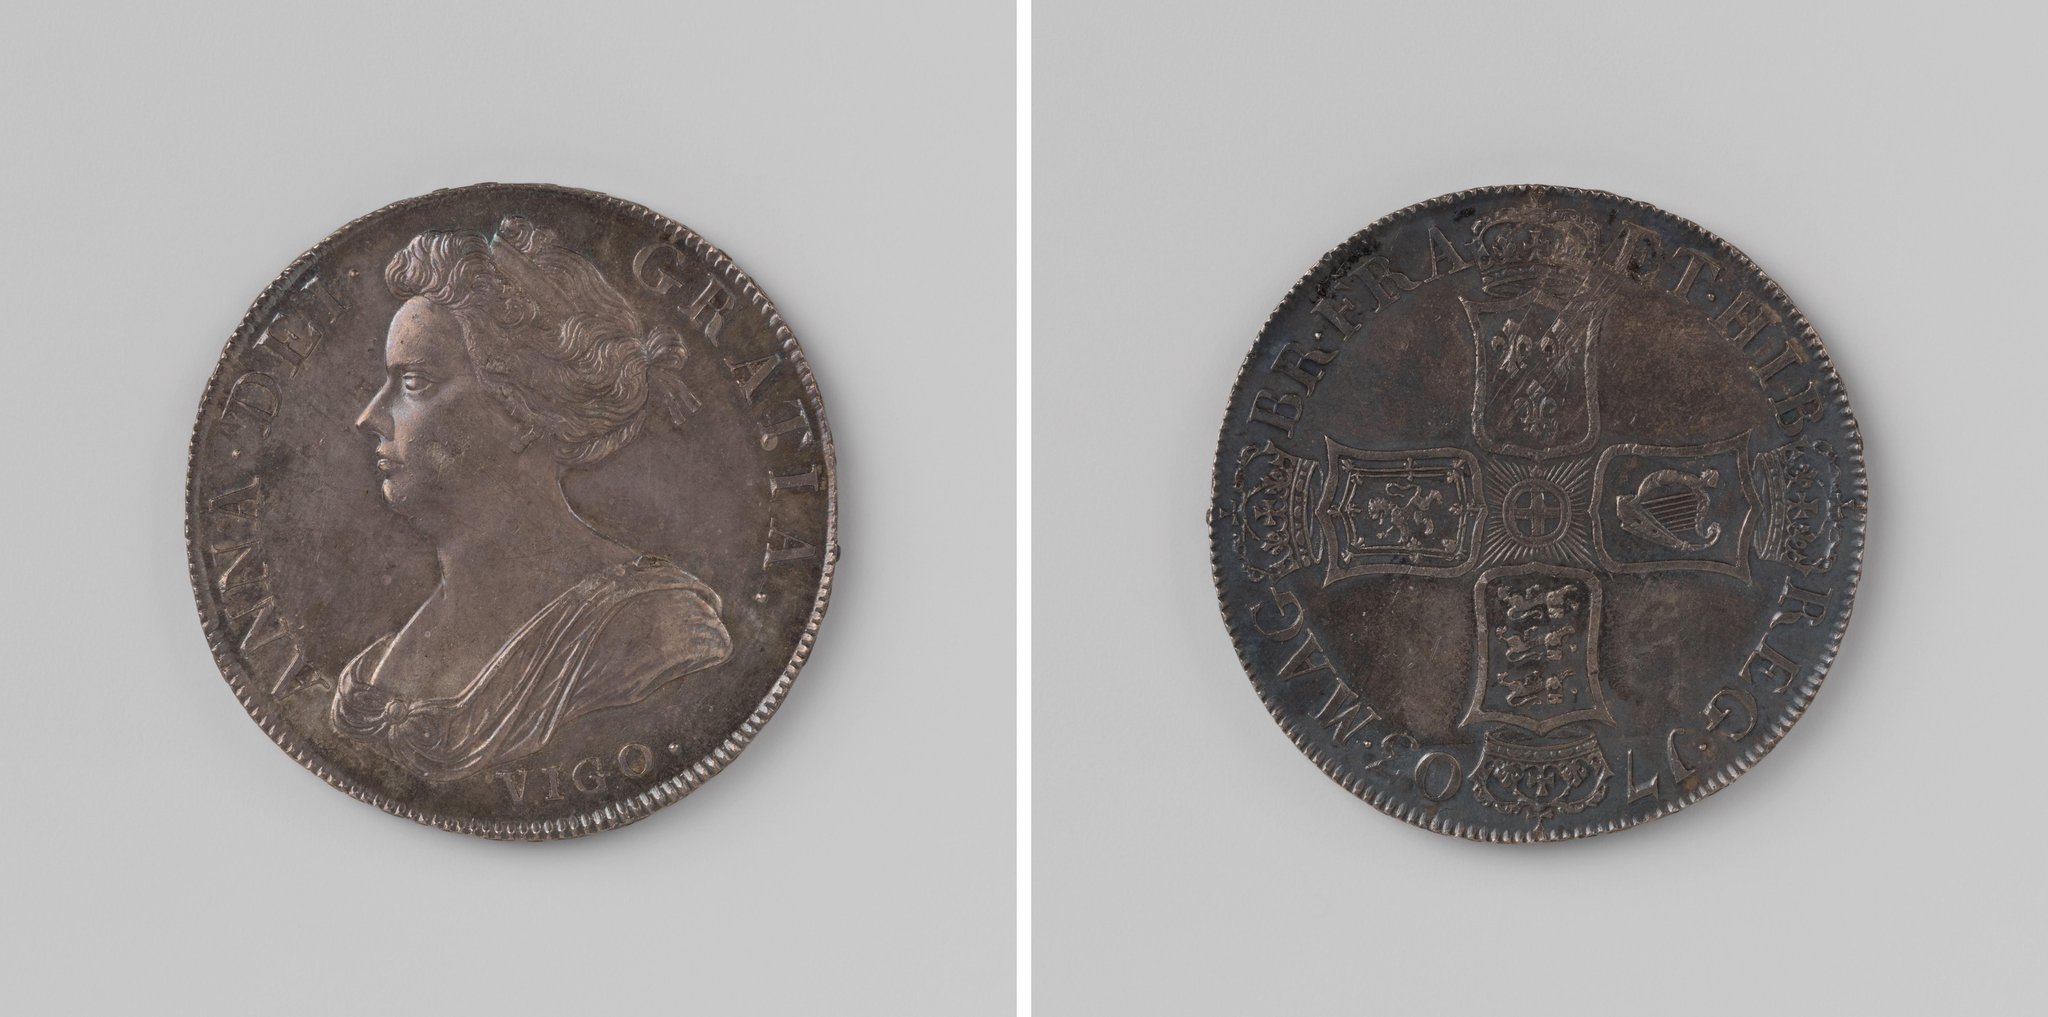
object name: crown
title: Anna, koningin van Engeland, munt geslagen van het in de zeeslag bij Vigo veroverde zilver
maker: Anonymous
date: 1703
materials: silver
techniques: striking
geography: england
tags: london, anna stuart (koningin van engeland en schotland)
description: Voorzijde: borststuk vrouw binnen omschrift. Keerzijde: rondom Engelse ster vier gekroonde wapenschilden binnen omschrift; randschrift